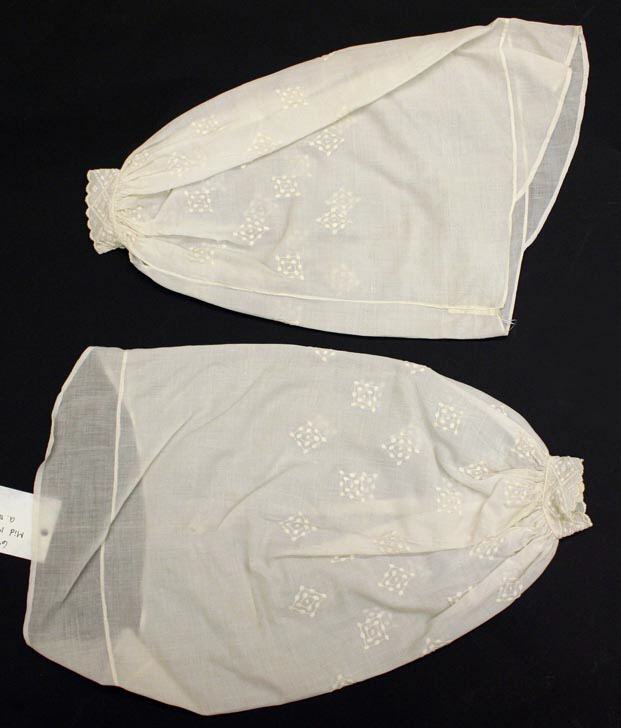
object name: undersleeves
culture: american or european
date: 1834-1866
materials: cotton